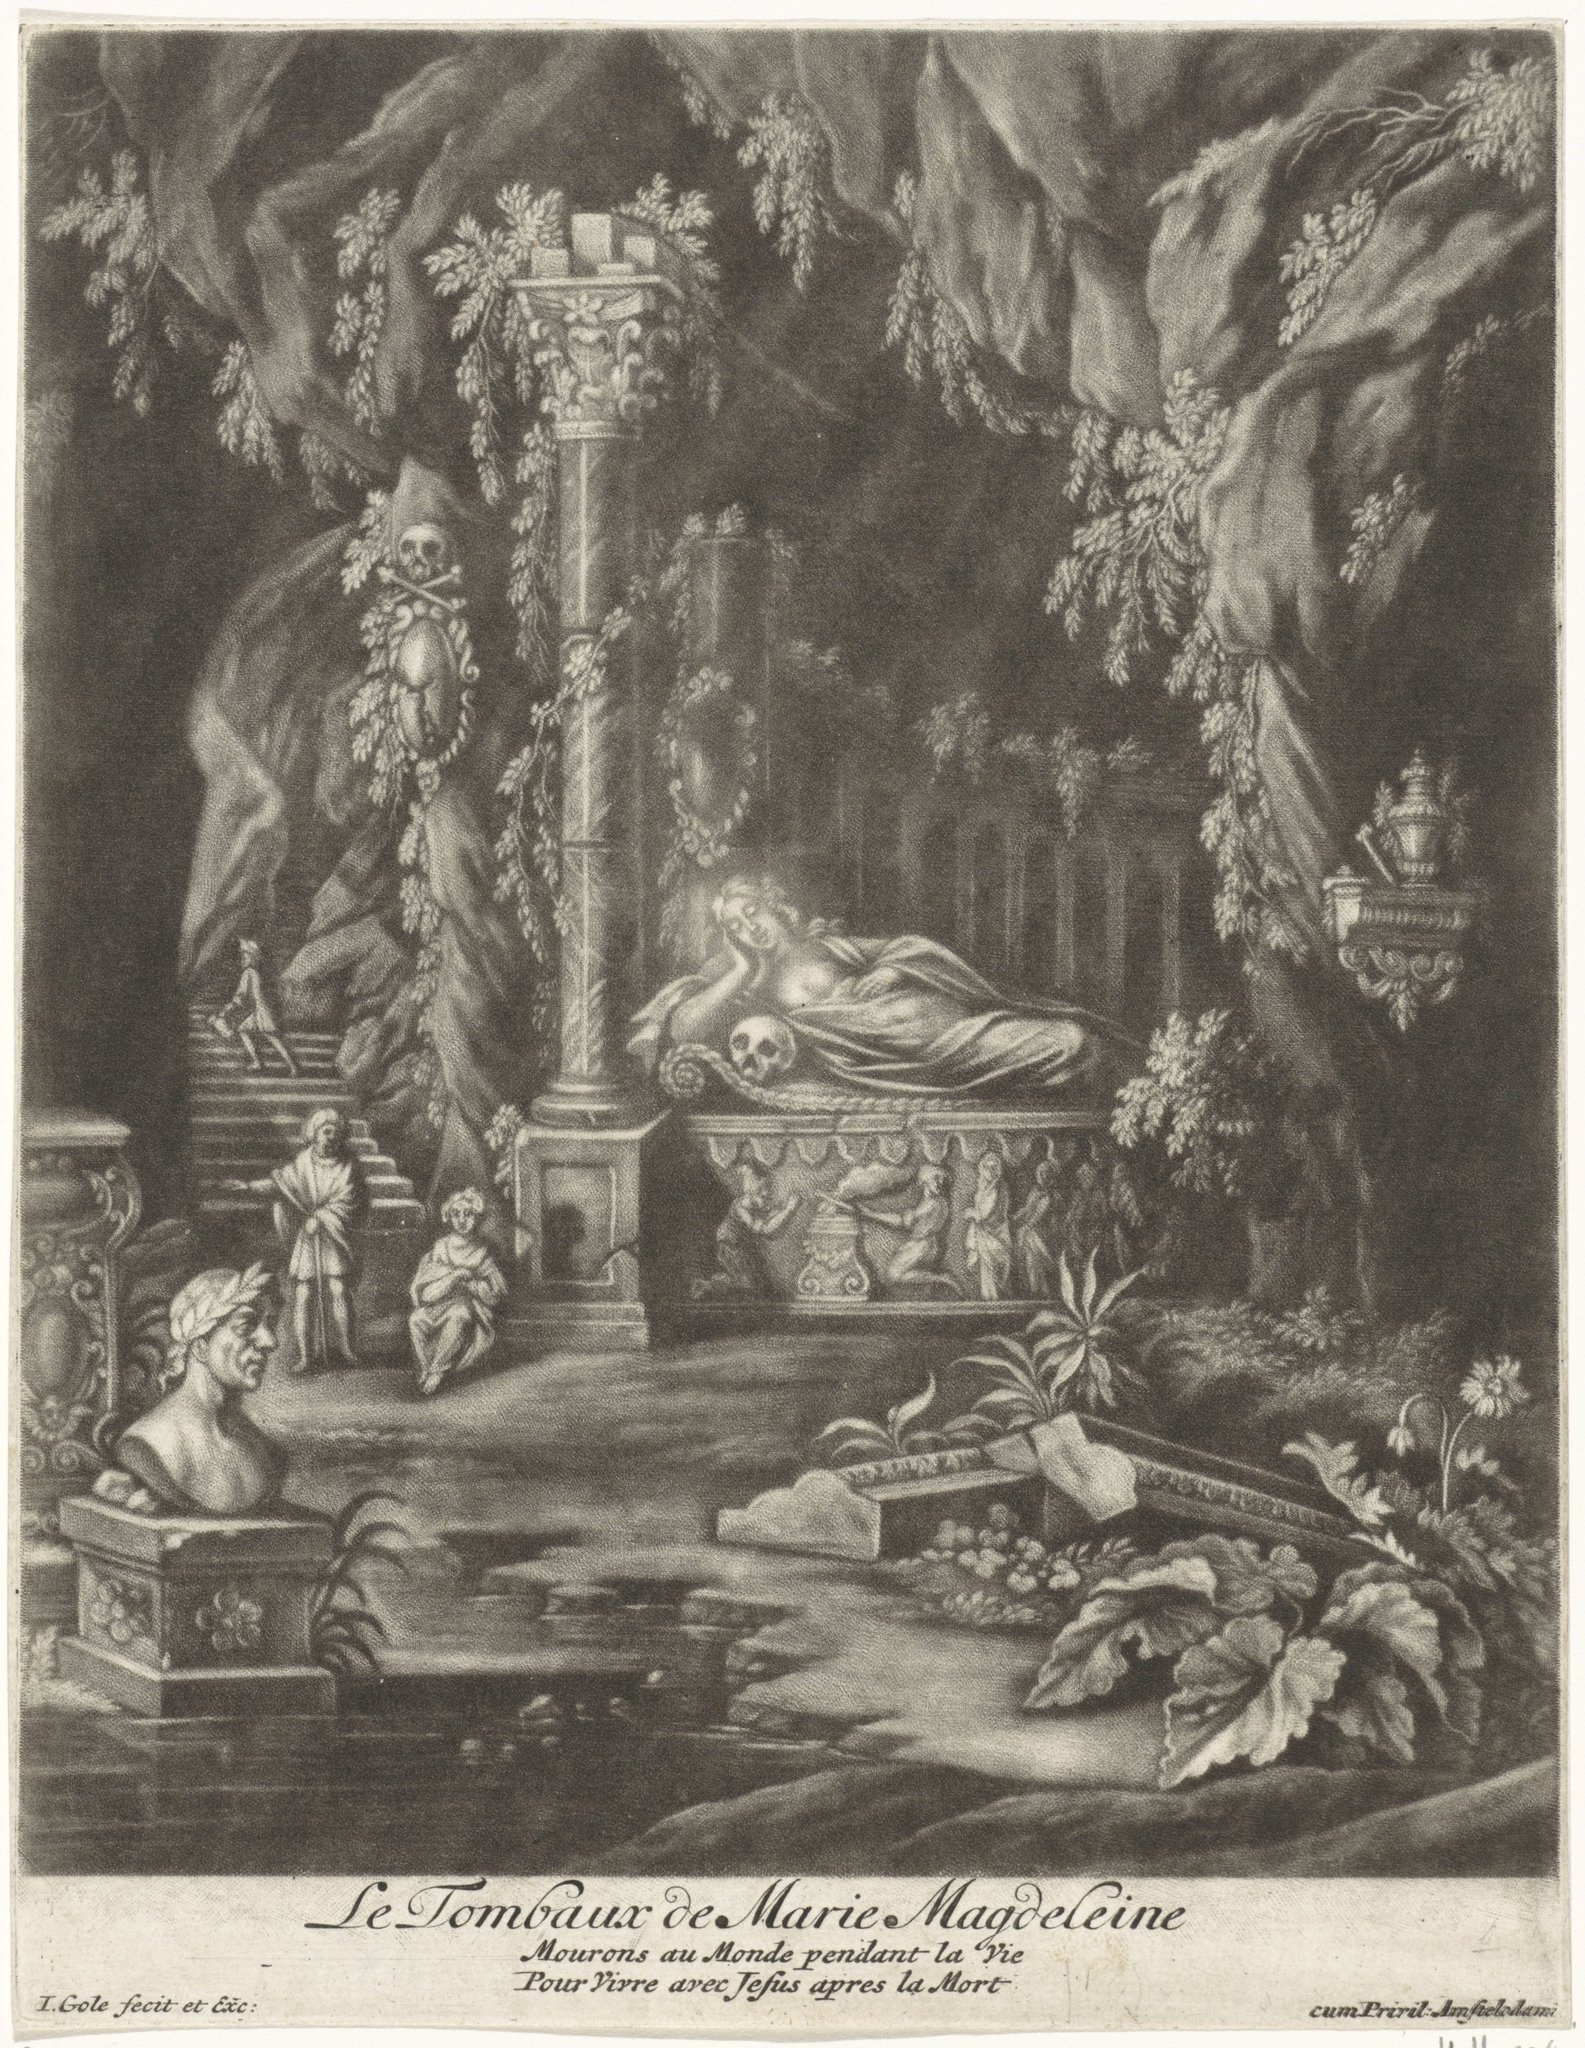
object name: print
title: Graftombe van Maria Magdalena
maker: jacob gole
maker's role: print maker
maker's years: 1660-1724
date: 1670-1724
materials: paper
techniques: engraving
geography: amsterdam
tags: grave, tomb, the penitent harlot mary magdalene; possible attributes: book (or scroll), crown, crown of thorns, crucifix, jar of ointment, mirror, musical instrument, palm-branch, rosary, scourge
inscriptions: collector's mark: Lugt 2228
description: Een aantal figuren bij de graftombe van Maria Magdalena in een grot.